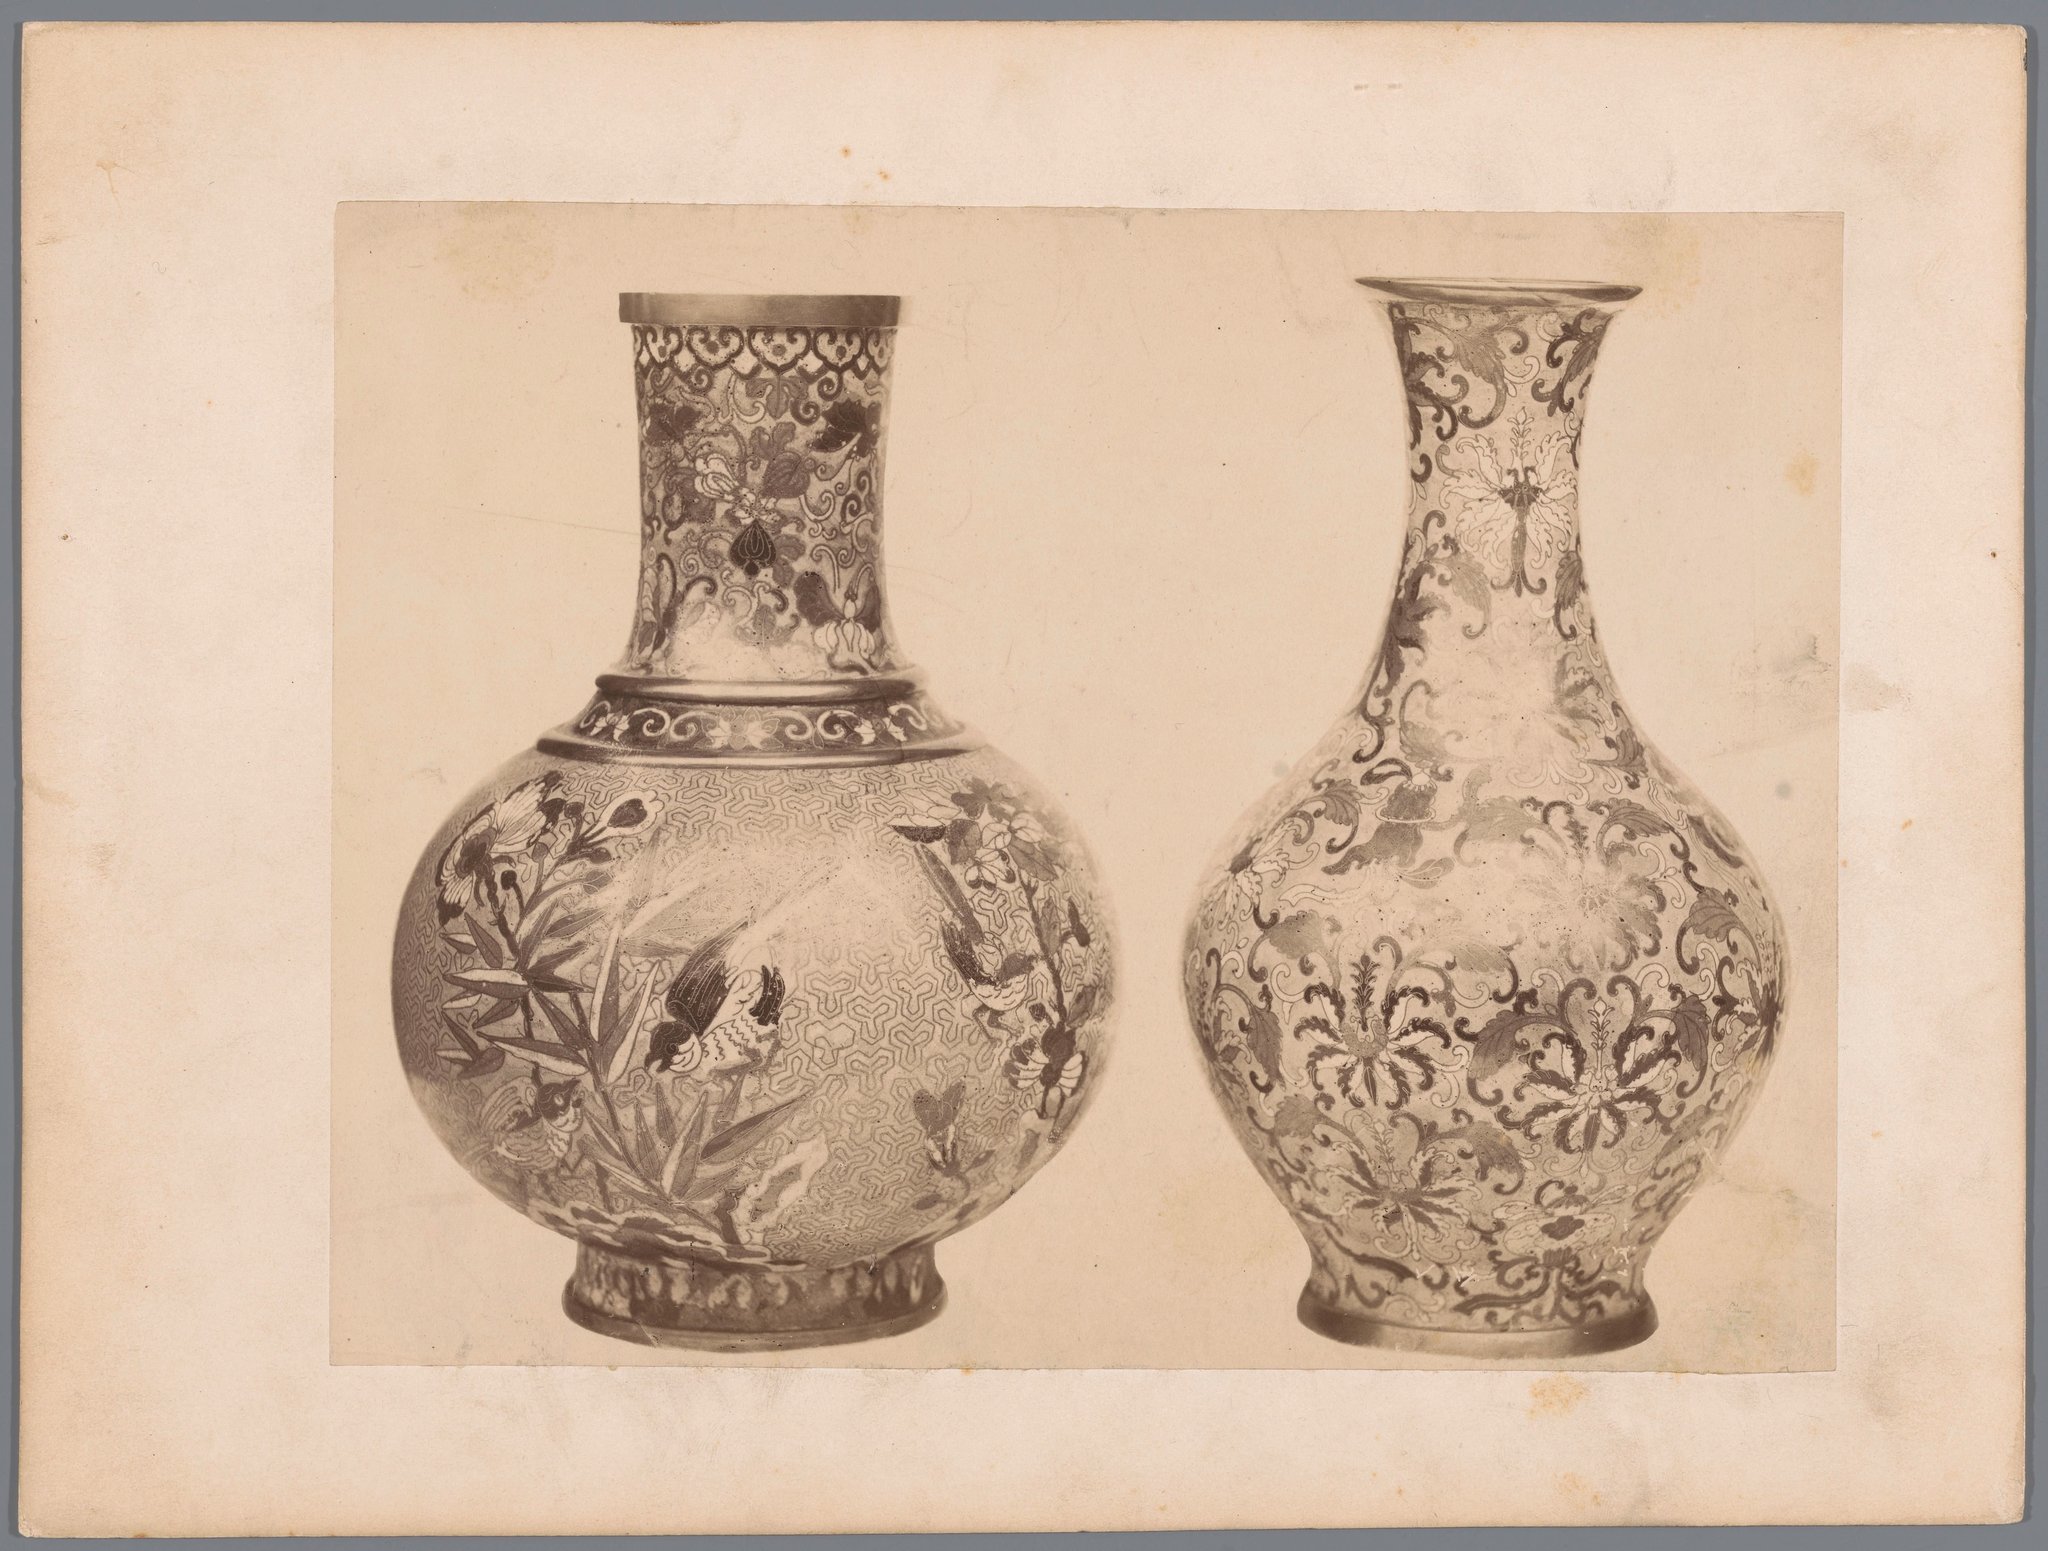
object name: photograph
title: Twee vazen gedecoreerd met bloemmotieven en vogels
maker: Anonymous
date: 1875-1900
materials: cardboard, photographic support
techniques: albumen print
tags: ornamental birds, container of ceramics: jar, jug, pot, vase, ornamenting, decorating ~ applied arts, flowers ~ ornament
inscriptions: collector's mark: Lugt 3937